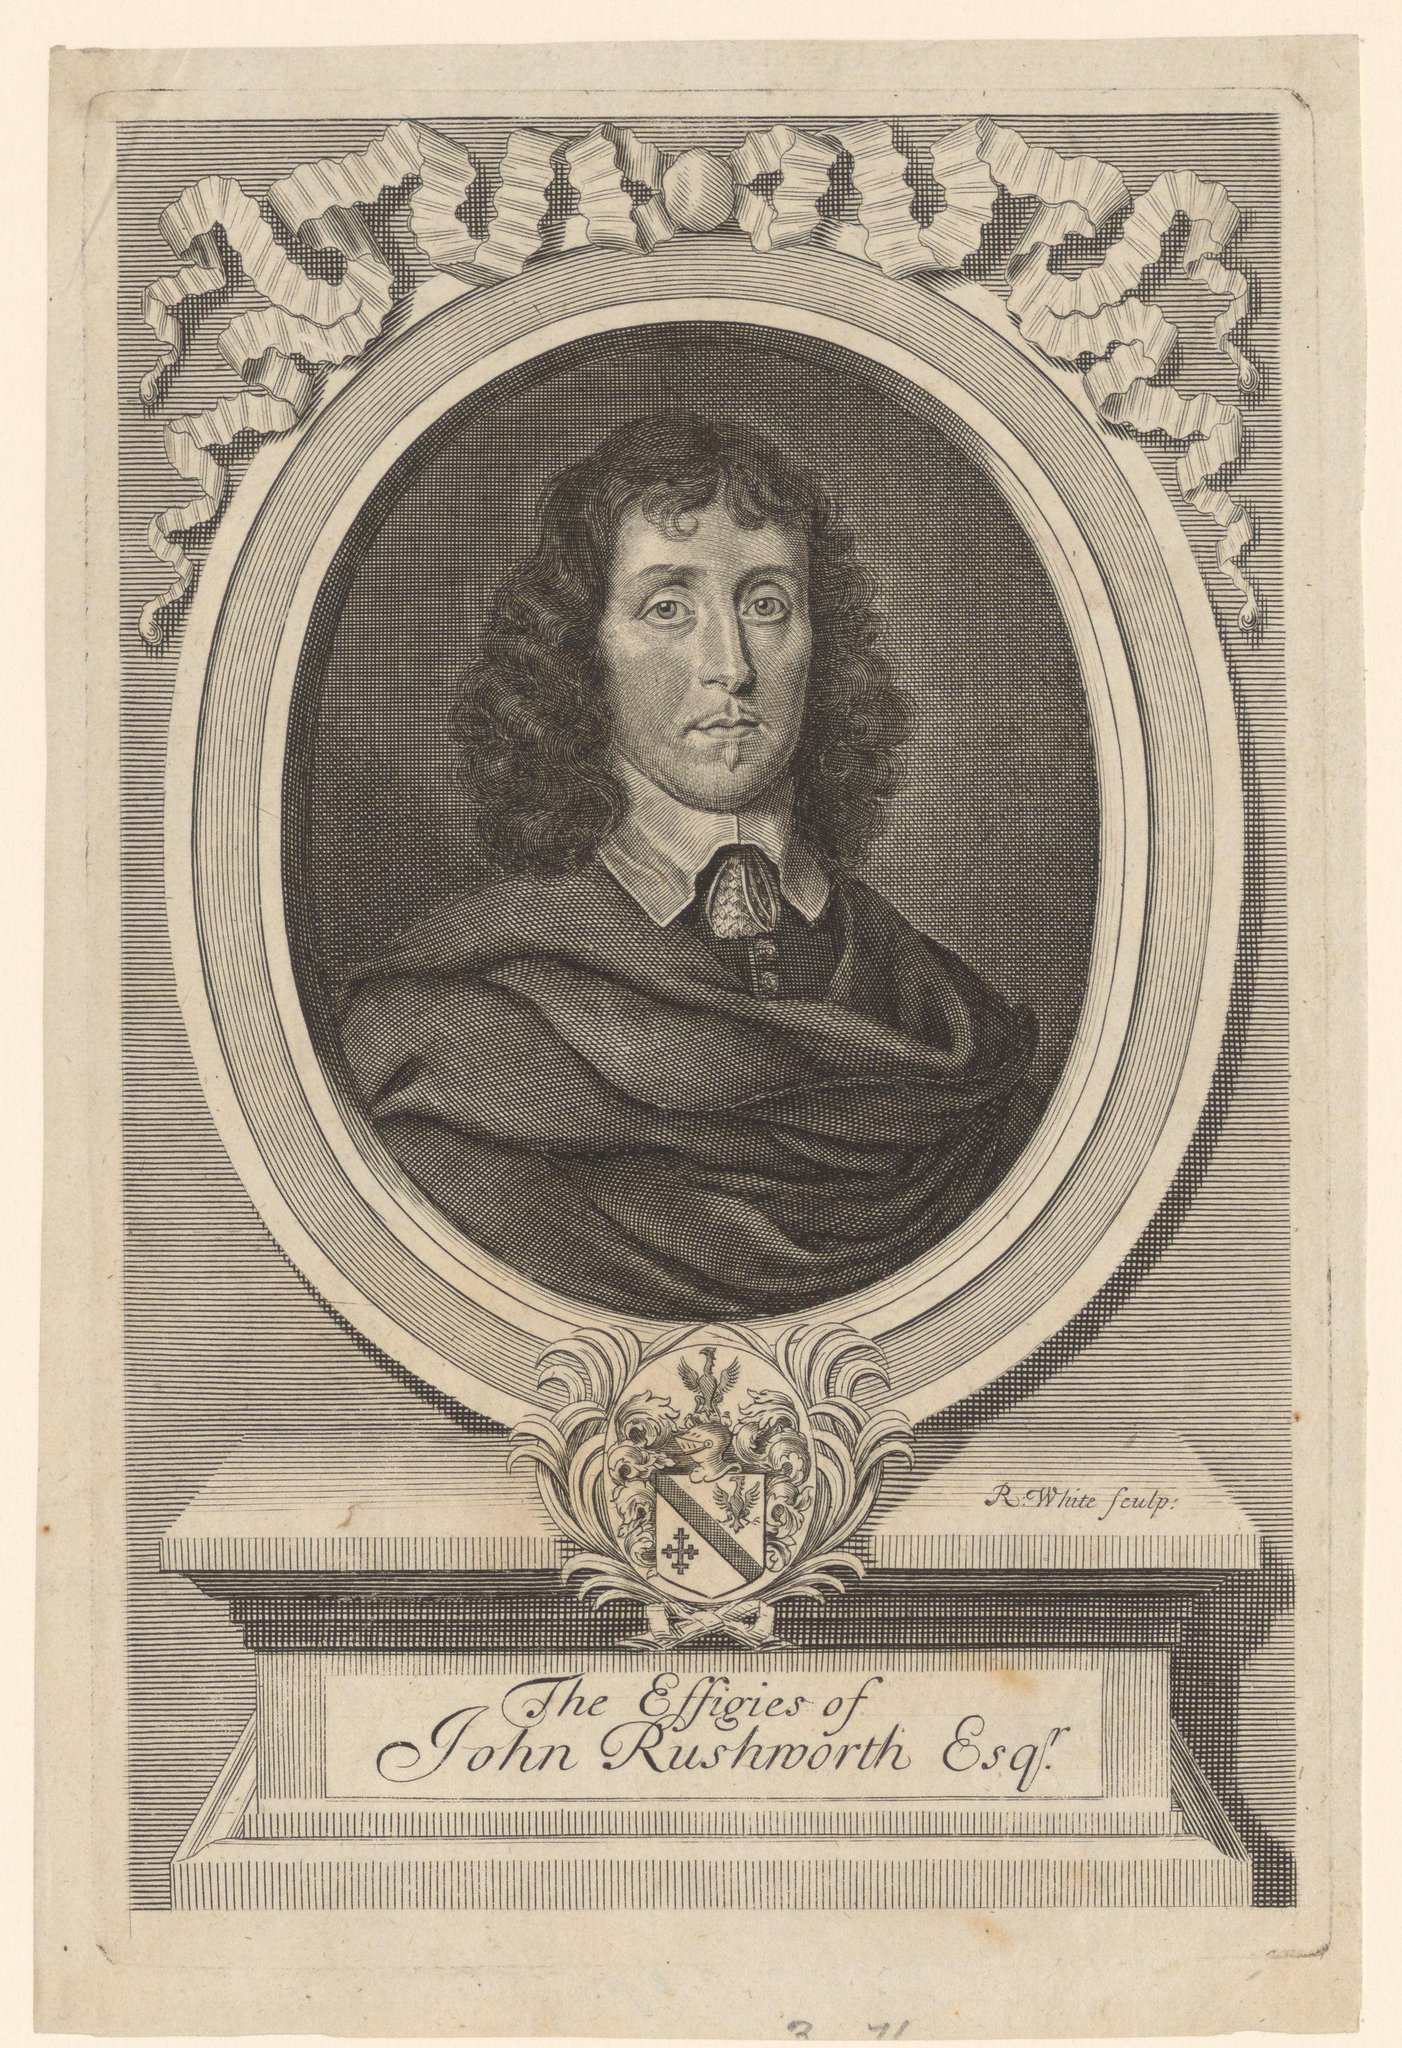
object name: book illustration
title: Portret van John Rushworth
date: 1692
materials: paper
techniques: engraving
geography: london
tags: politician, historical persons, politician, e.g. party leader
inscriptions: collector's mark: Lugt 2228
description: Prent uit: Rushworth, John. Historical Collections of Private Passages of State (...) The Third Part. Londen: Richard Chiswell en Thomas Cockerill, 1692.